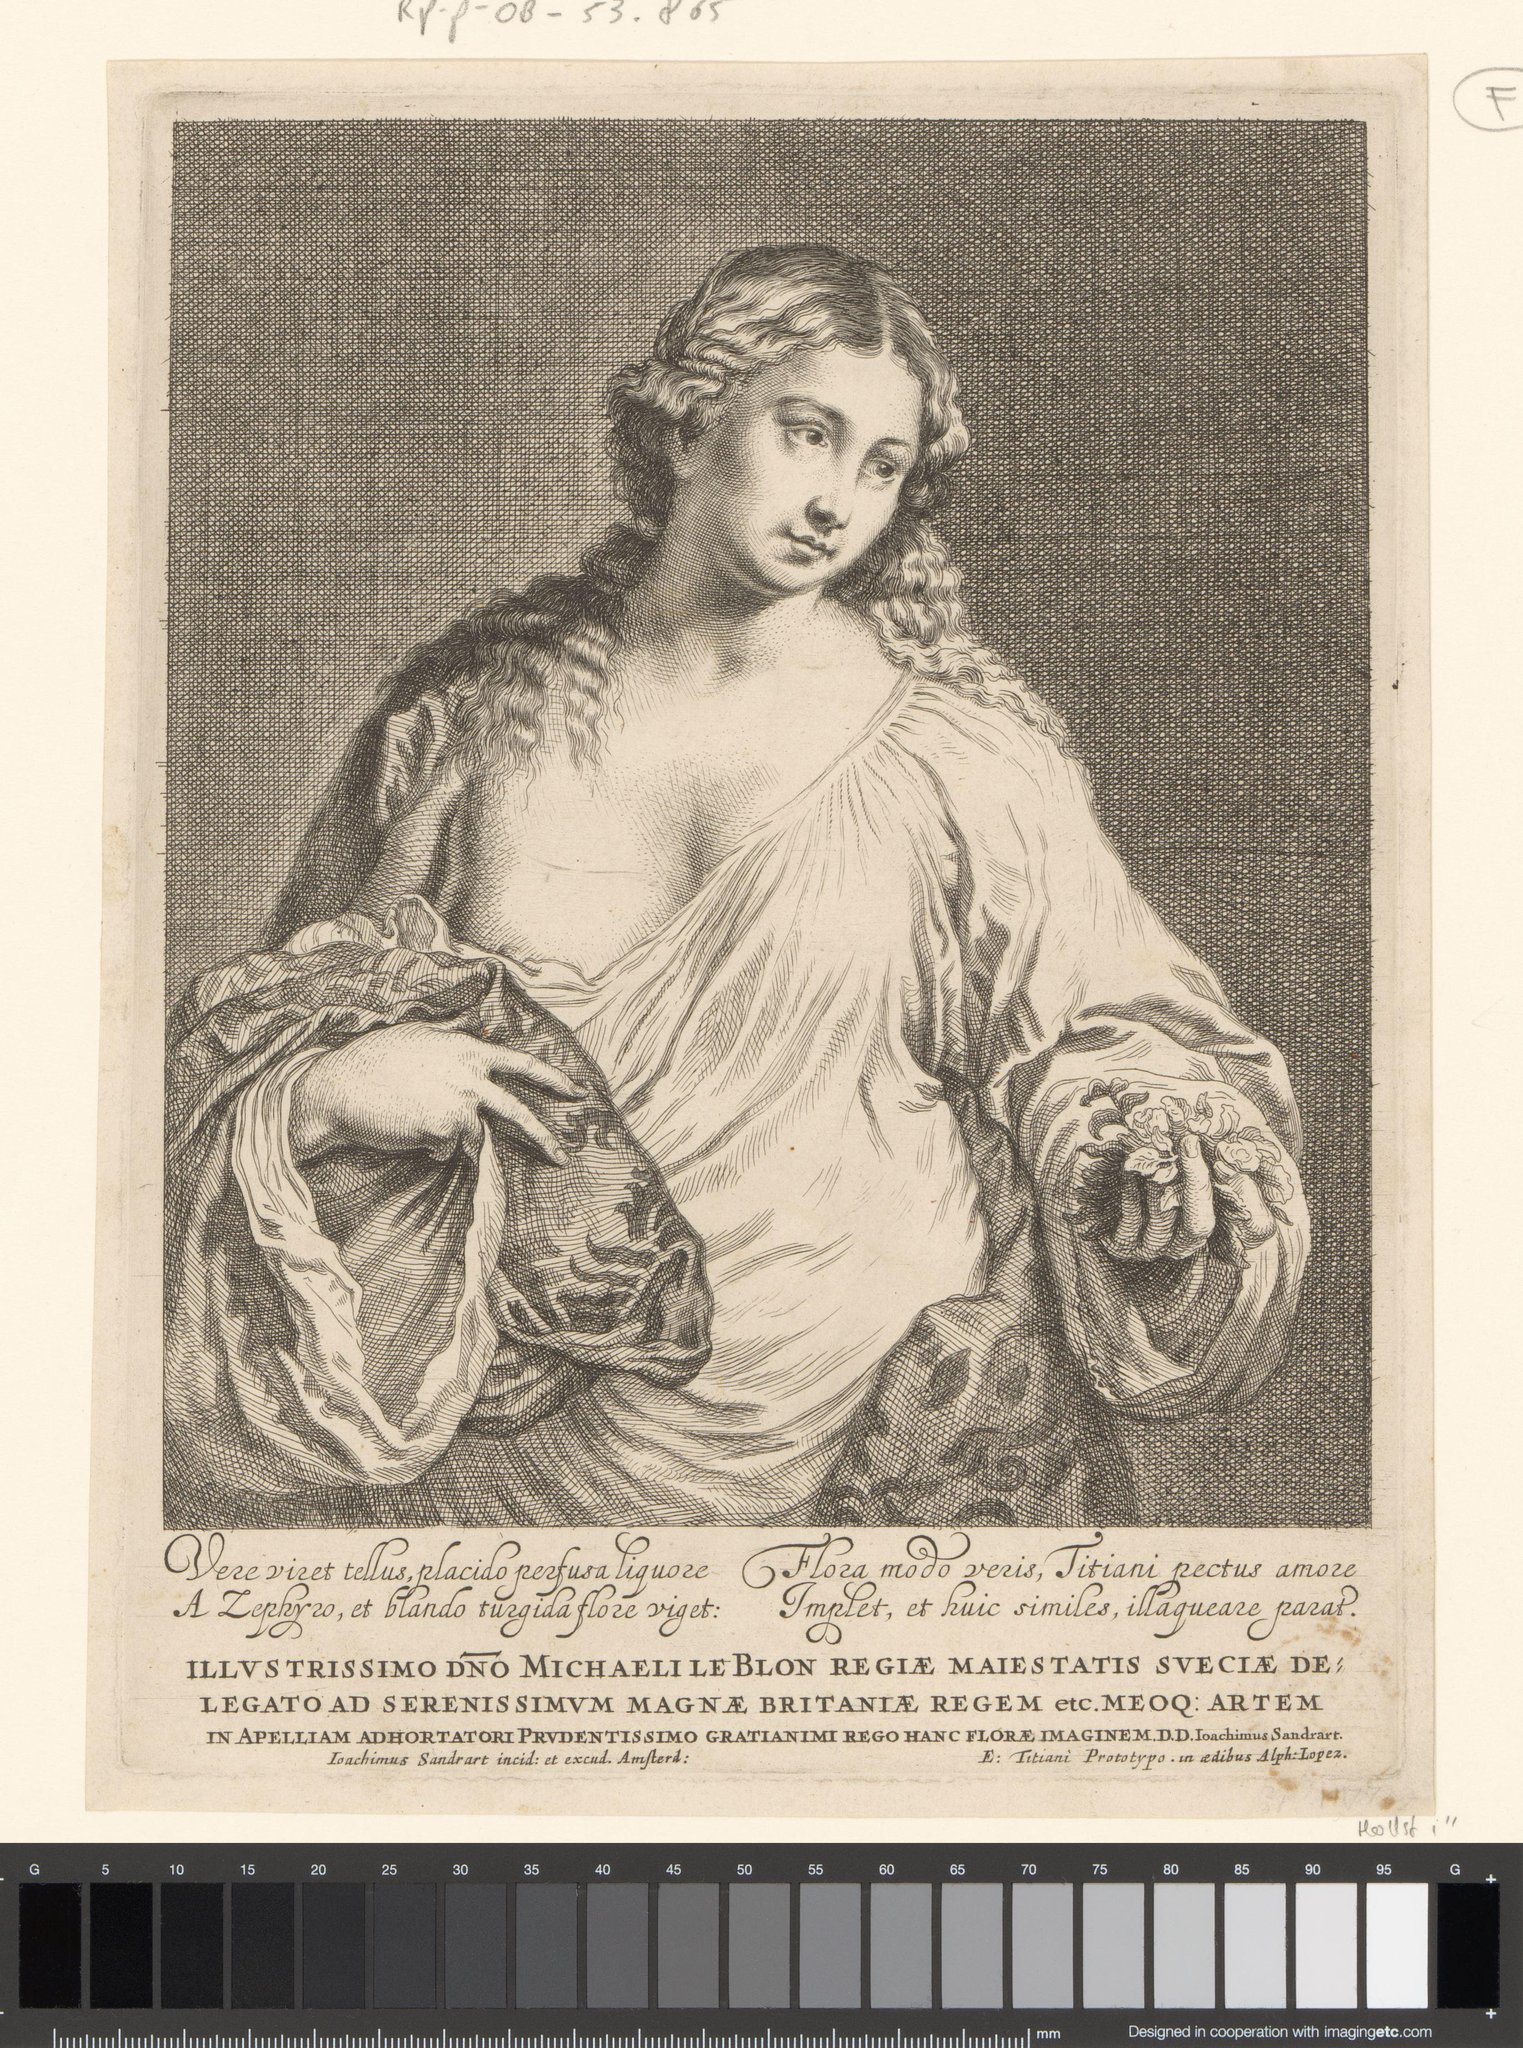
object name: print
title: Flora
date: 1616-1688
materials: paper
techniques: etching, letterpress printing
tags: (story of) flora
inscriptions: collector's mark: Lugt 240